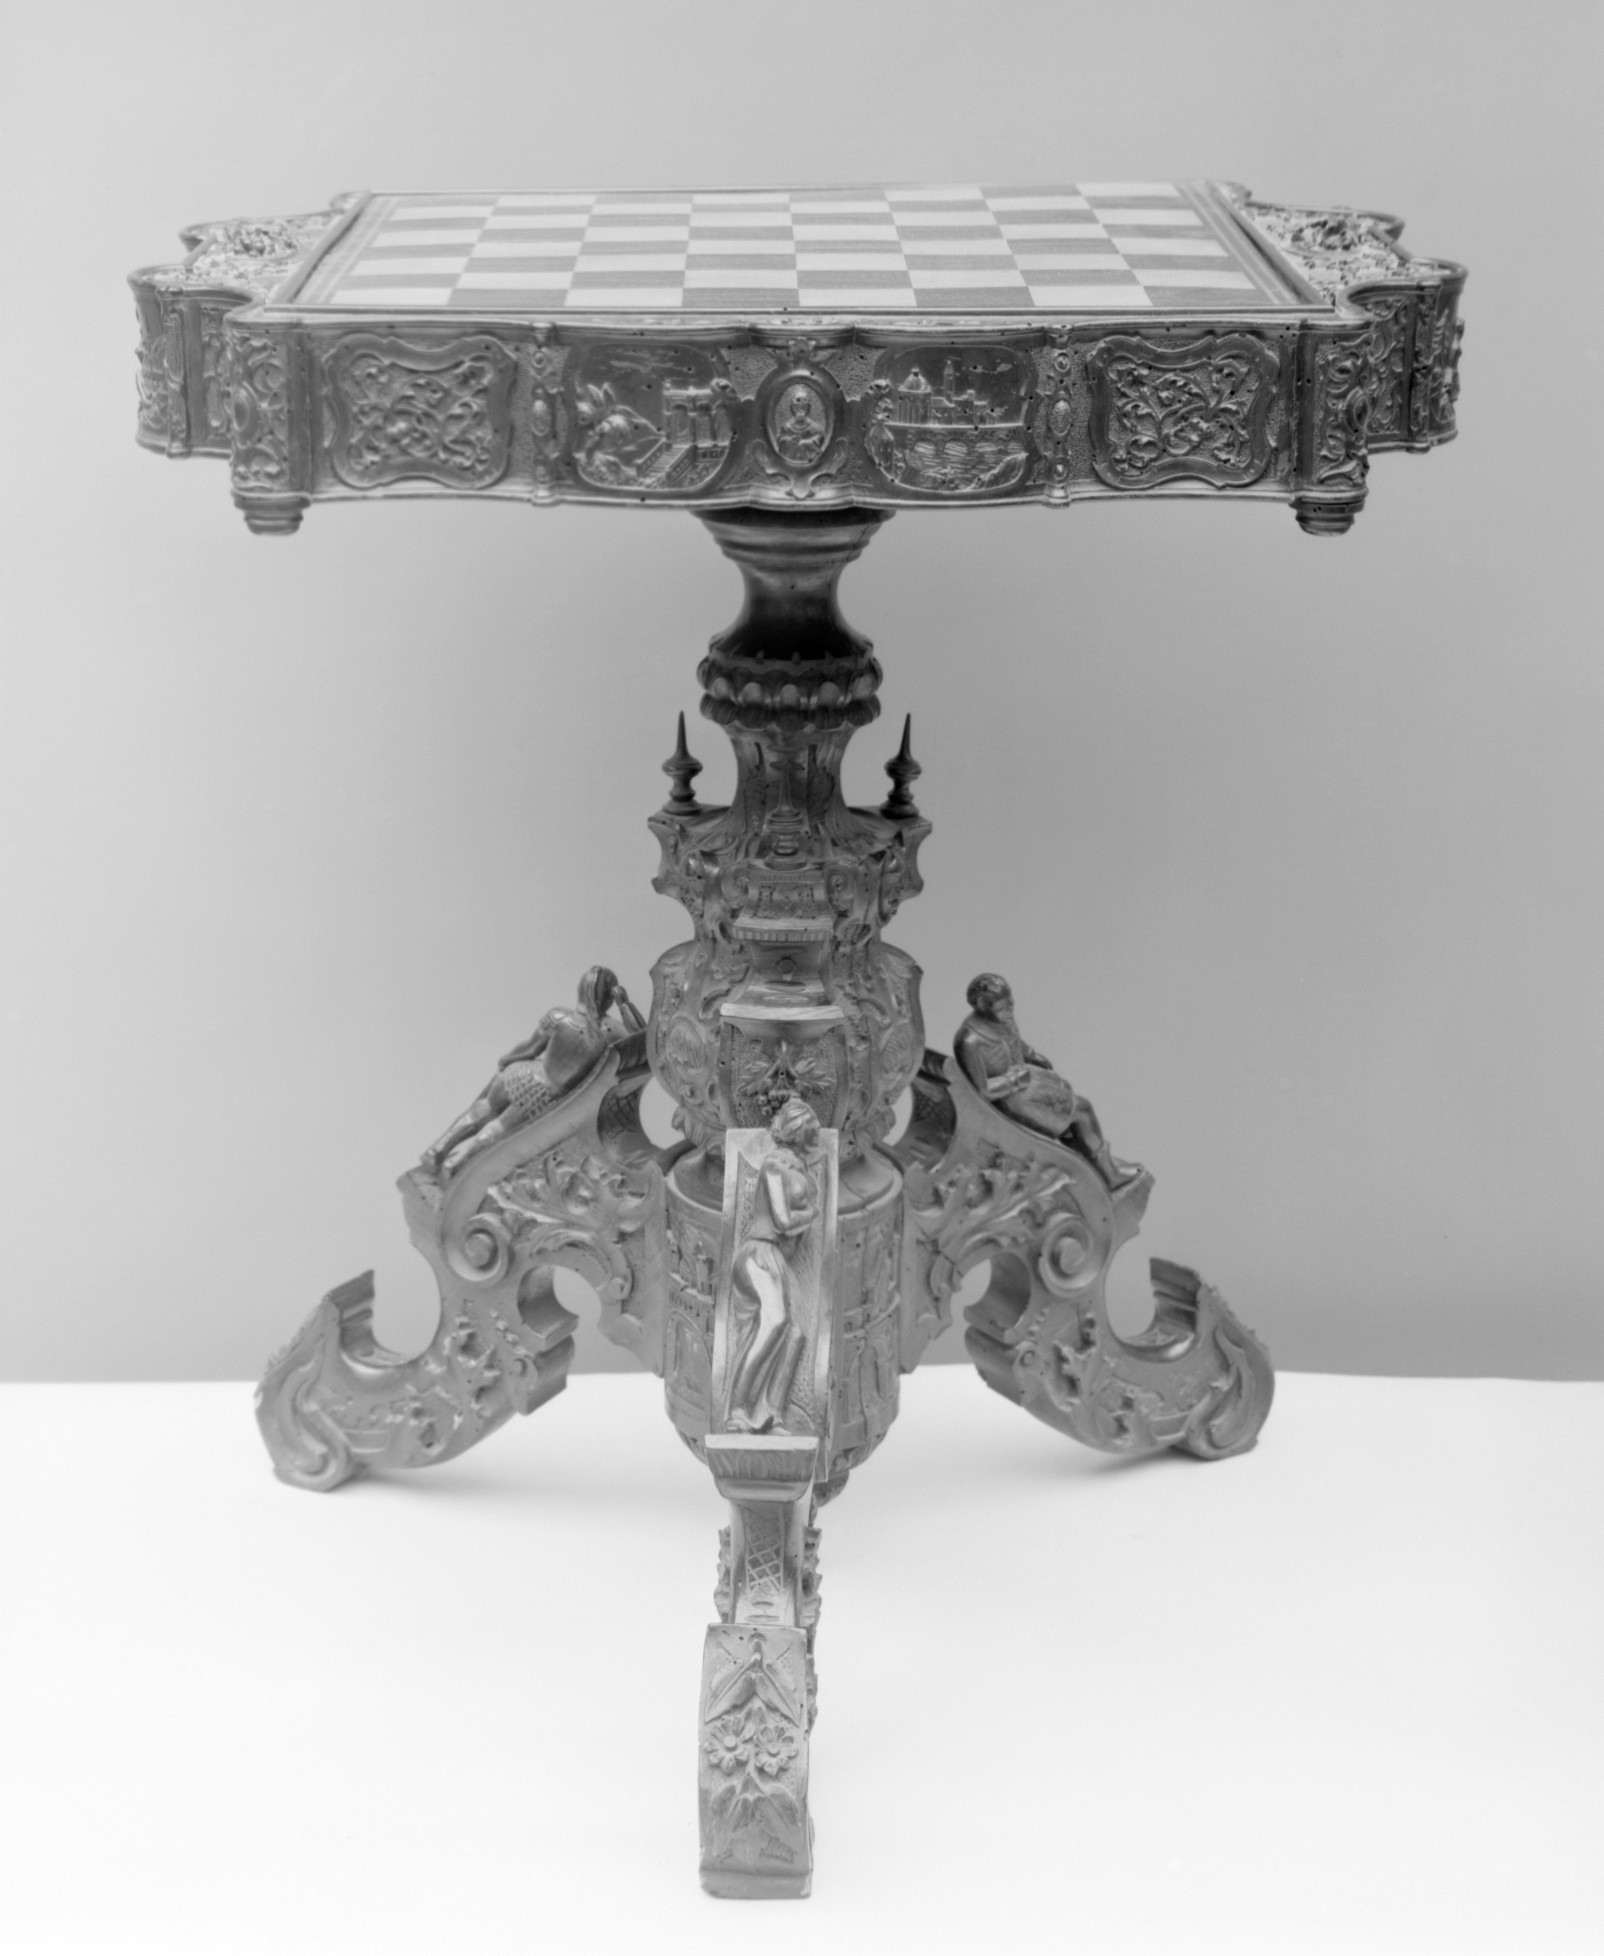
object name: chess table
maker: fabbrica c.v.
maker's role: maker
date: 1856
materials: wood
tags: chess